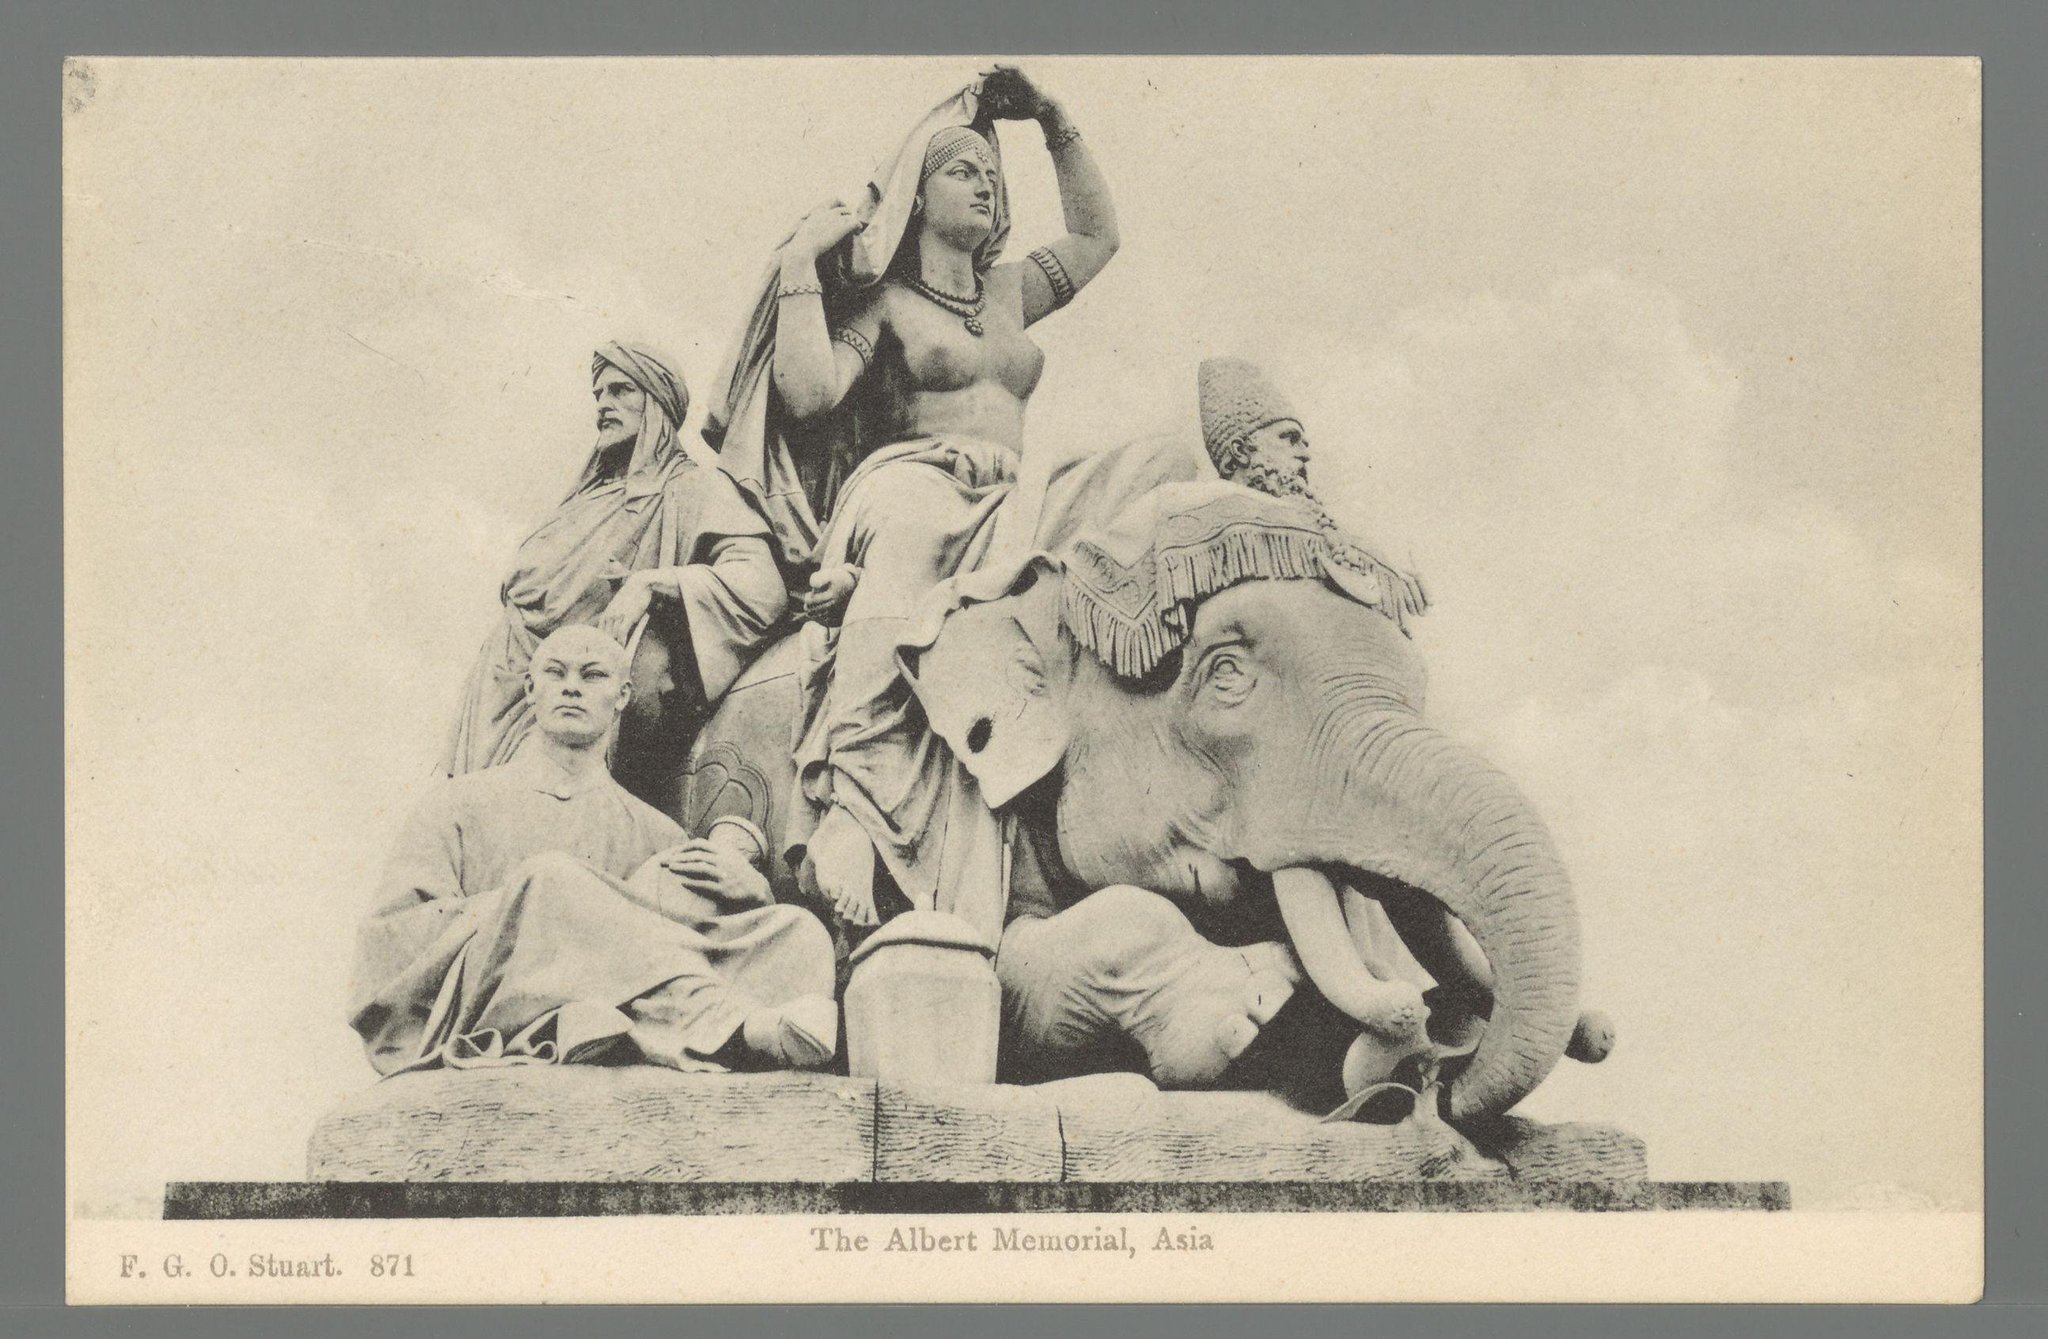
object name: ansichtkaart, prentbriefkaart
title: The Albert Memorial, Asia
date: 1902-1930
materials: cardboard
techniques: photograph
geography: germany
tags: asia represented allegorically; 'asia' (ripa), monument, statue, trunked animals: elephant